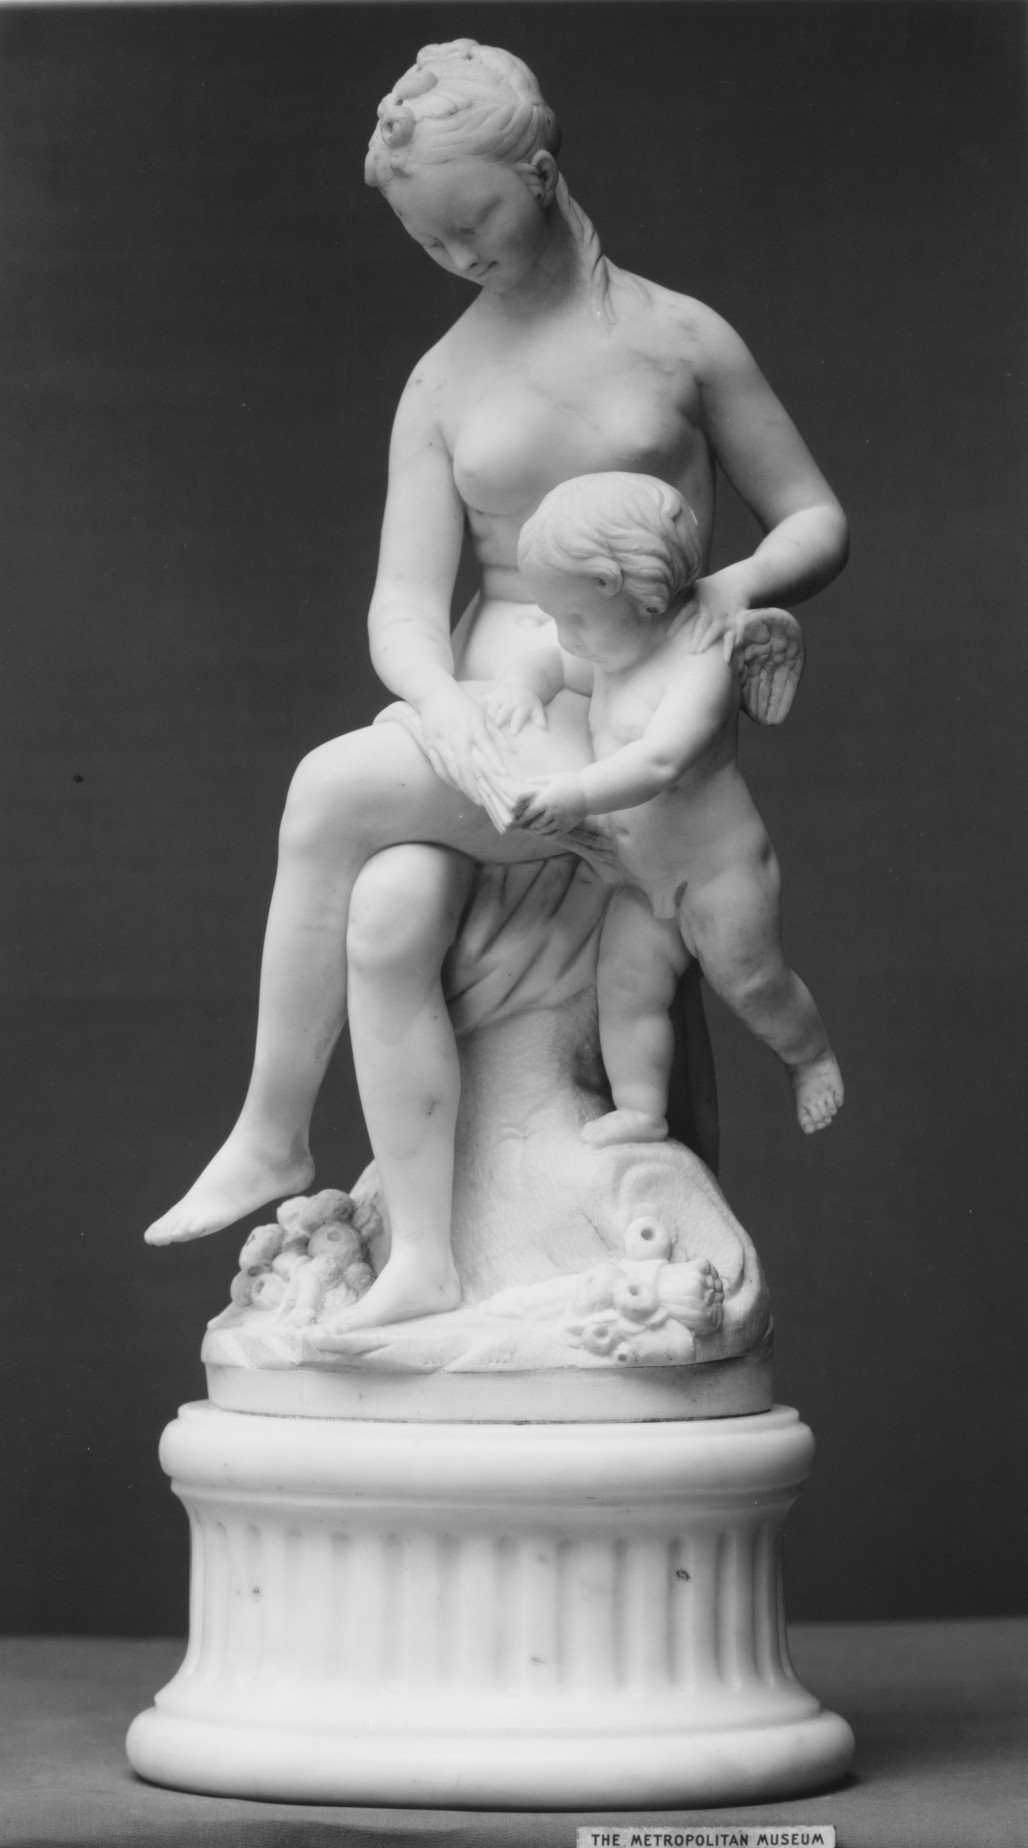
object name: group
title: Venus Instructing Cupid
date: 1780-1785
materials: marble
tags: cupid,venus